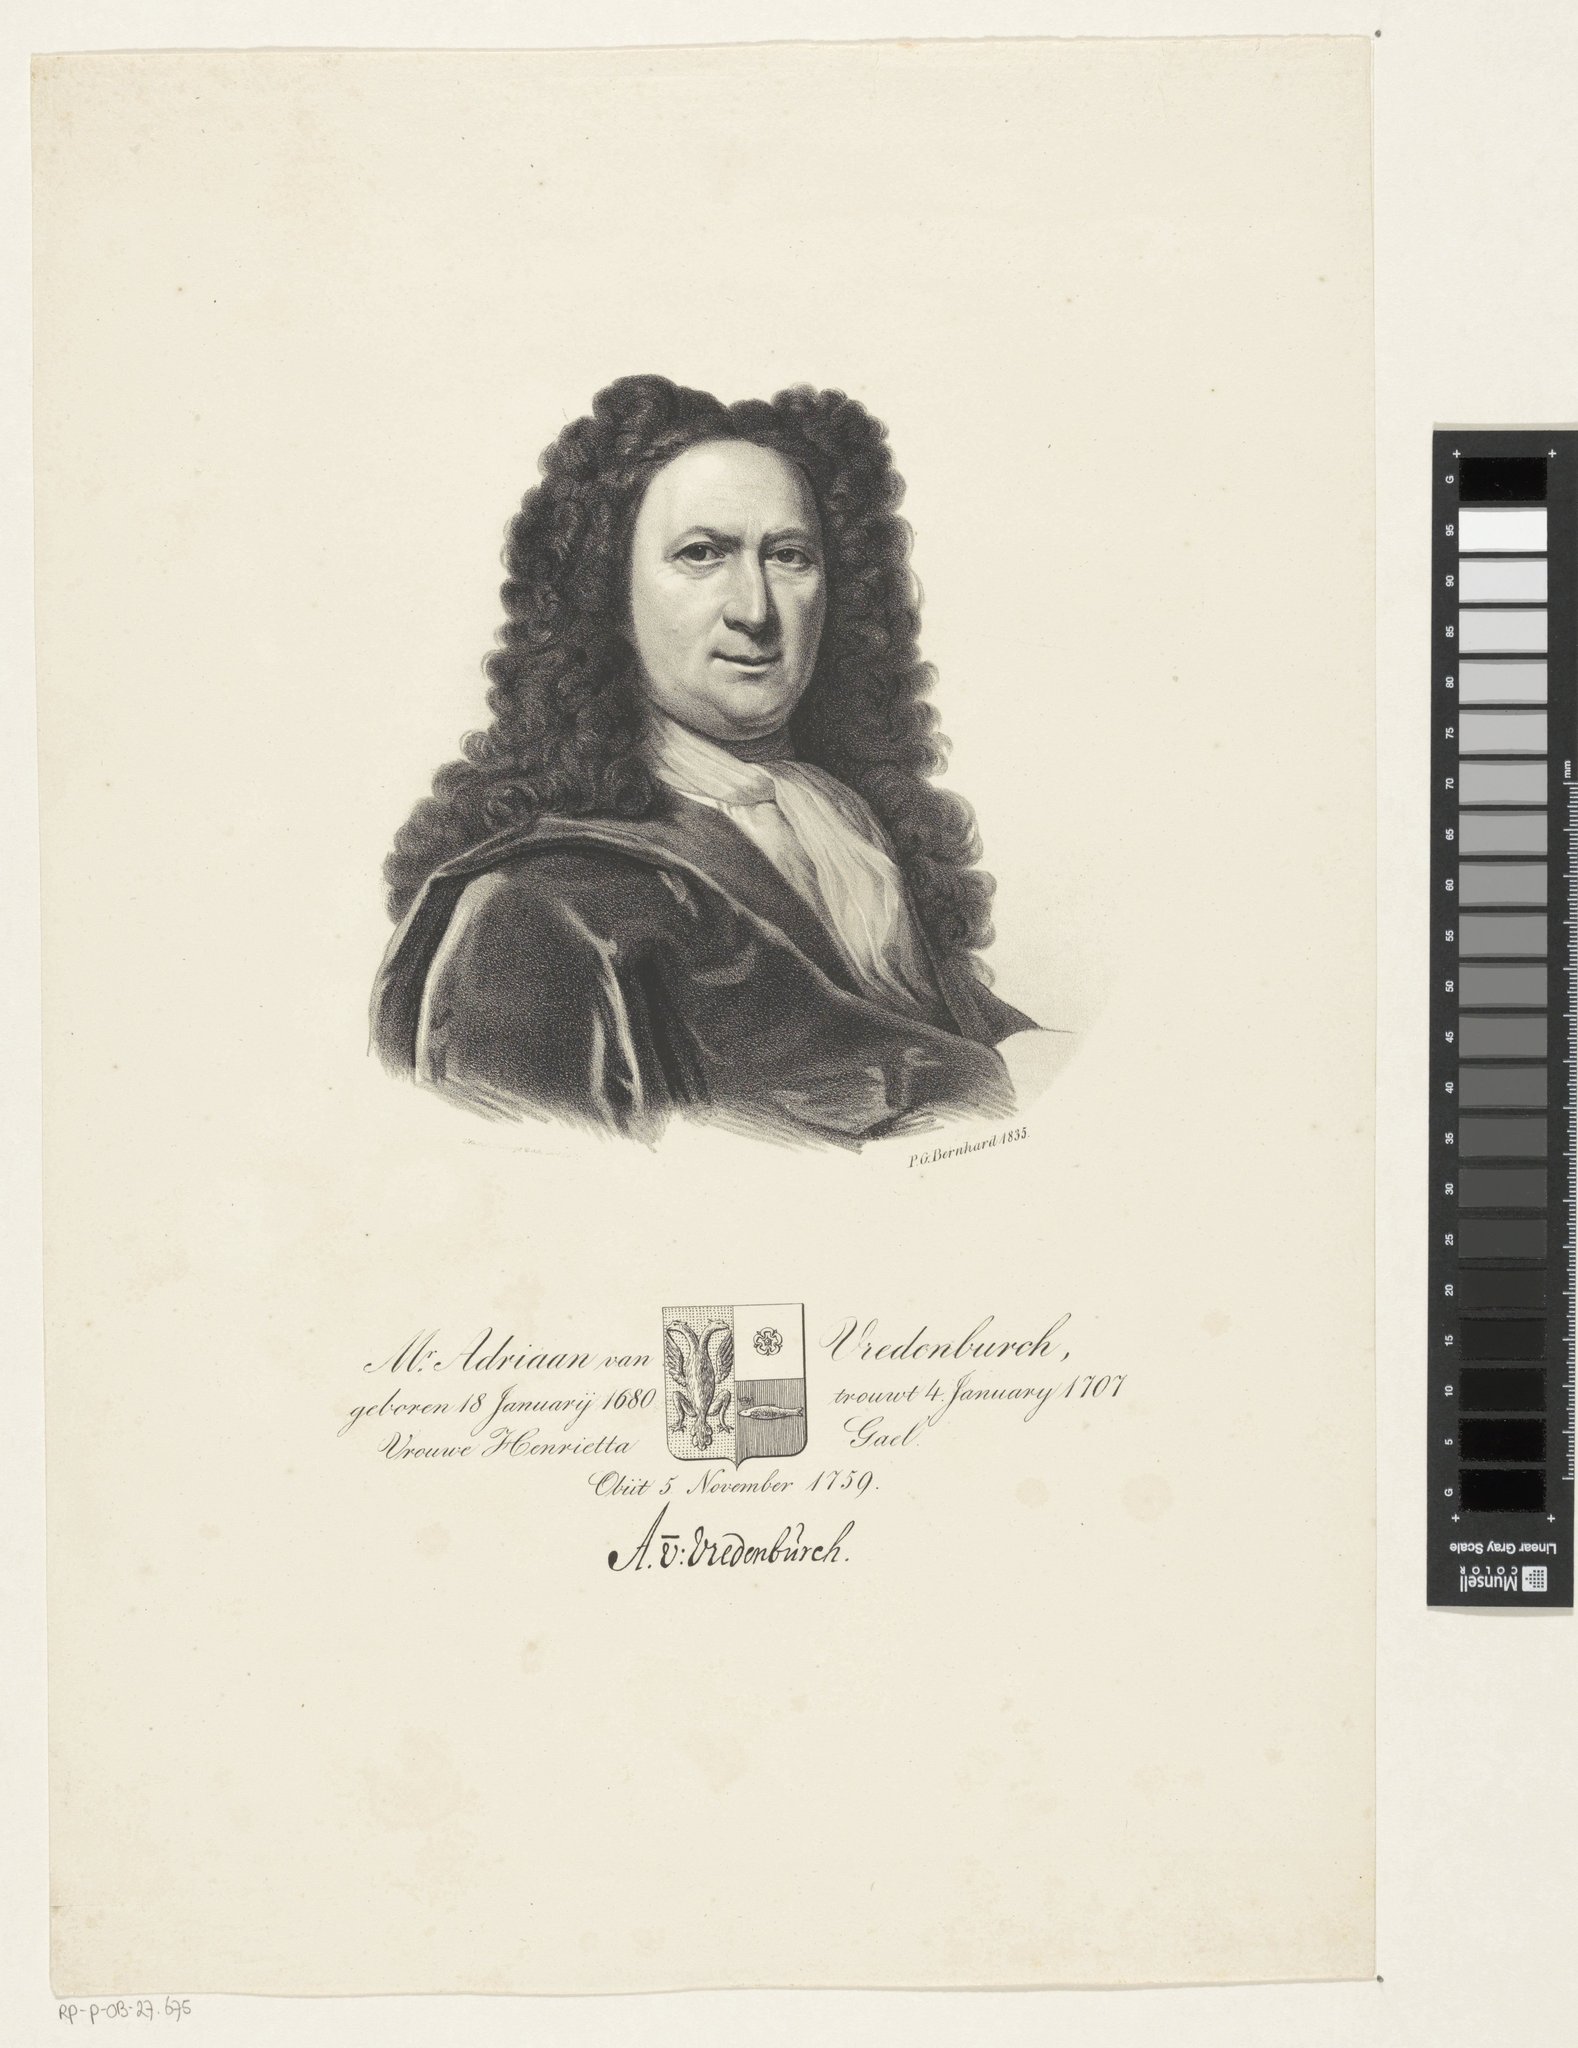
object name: print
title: Portret van Adriaan van Vredenburch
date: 1835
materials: paper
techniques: lithograph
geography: the hague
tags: historical persons, armorial bearing, heraldry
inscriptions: date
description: Onder het portret de naam, geboorte- trouw- en sterfdatum en het familiewapen van de geportretteerde. Daaronder de signatuur van de geportretteerde.